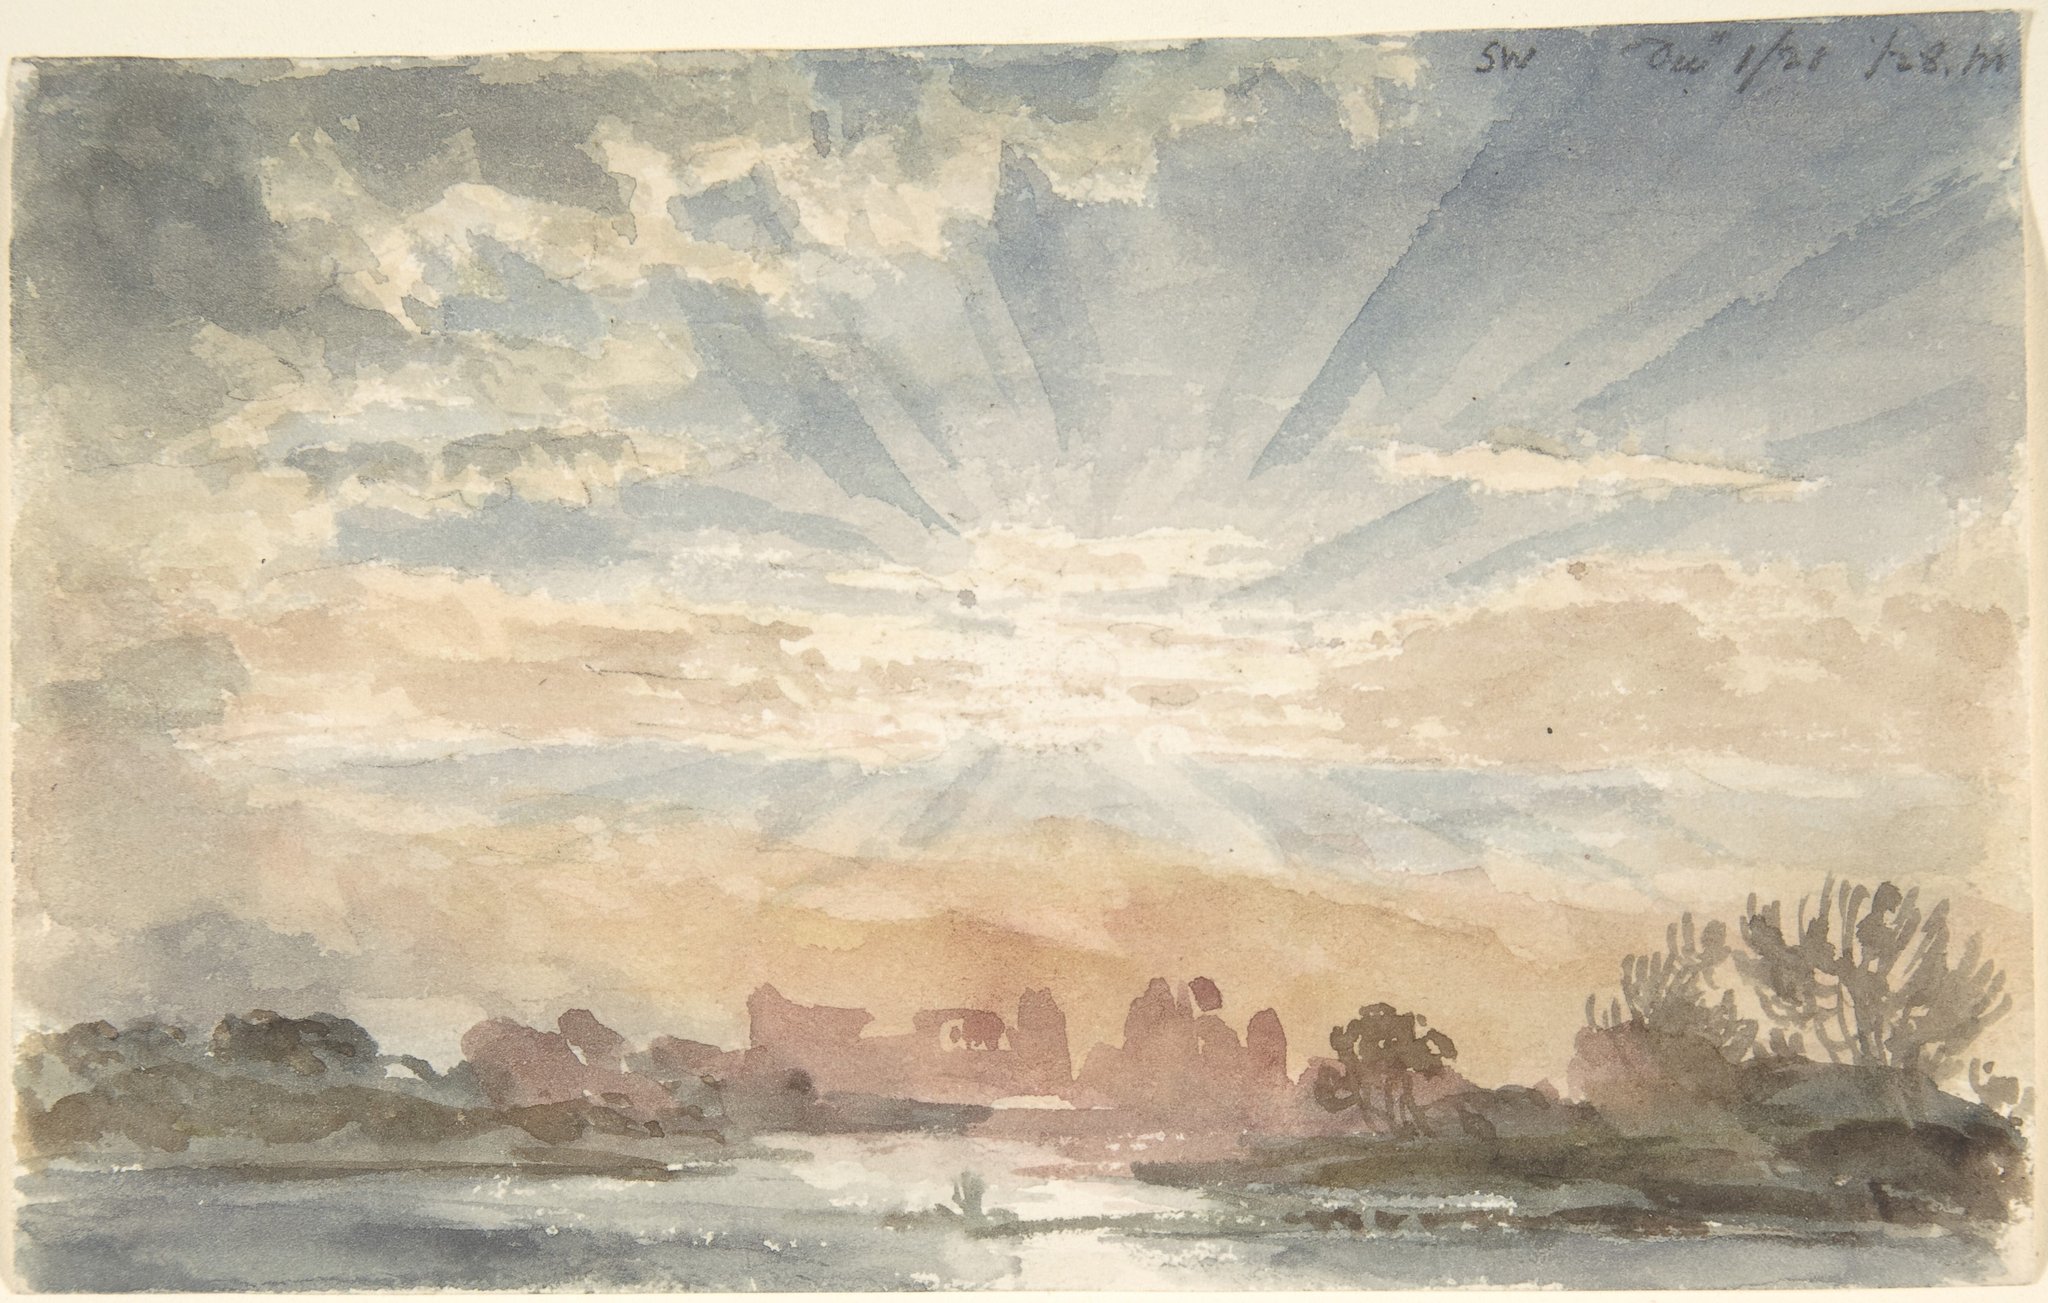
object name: drawing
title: Landscape with rising sun, December 1, 1828, 8:30 a.m.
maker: joseph michael gandy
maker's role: artist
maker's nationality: british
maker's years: 1771-1843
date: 1828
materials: graphite, watercolor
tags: sun,landscapes